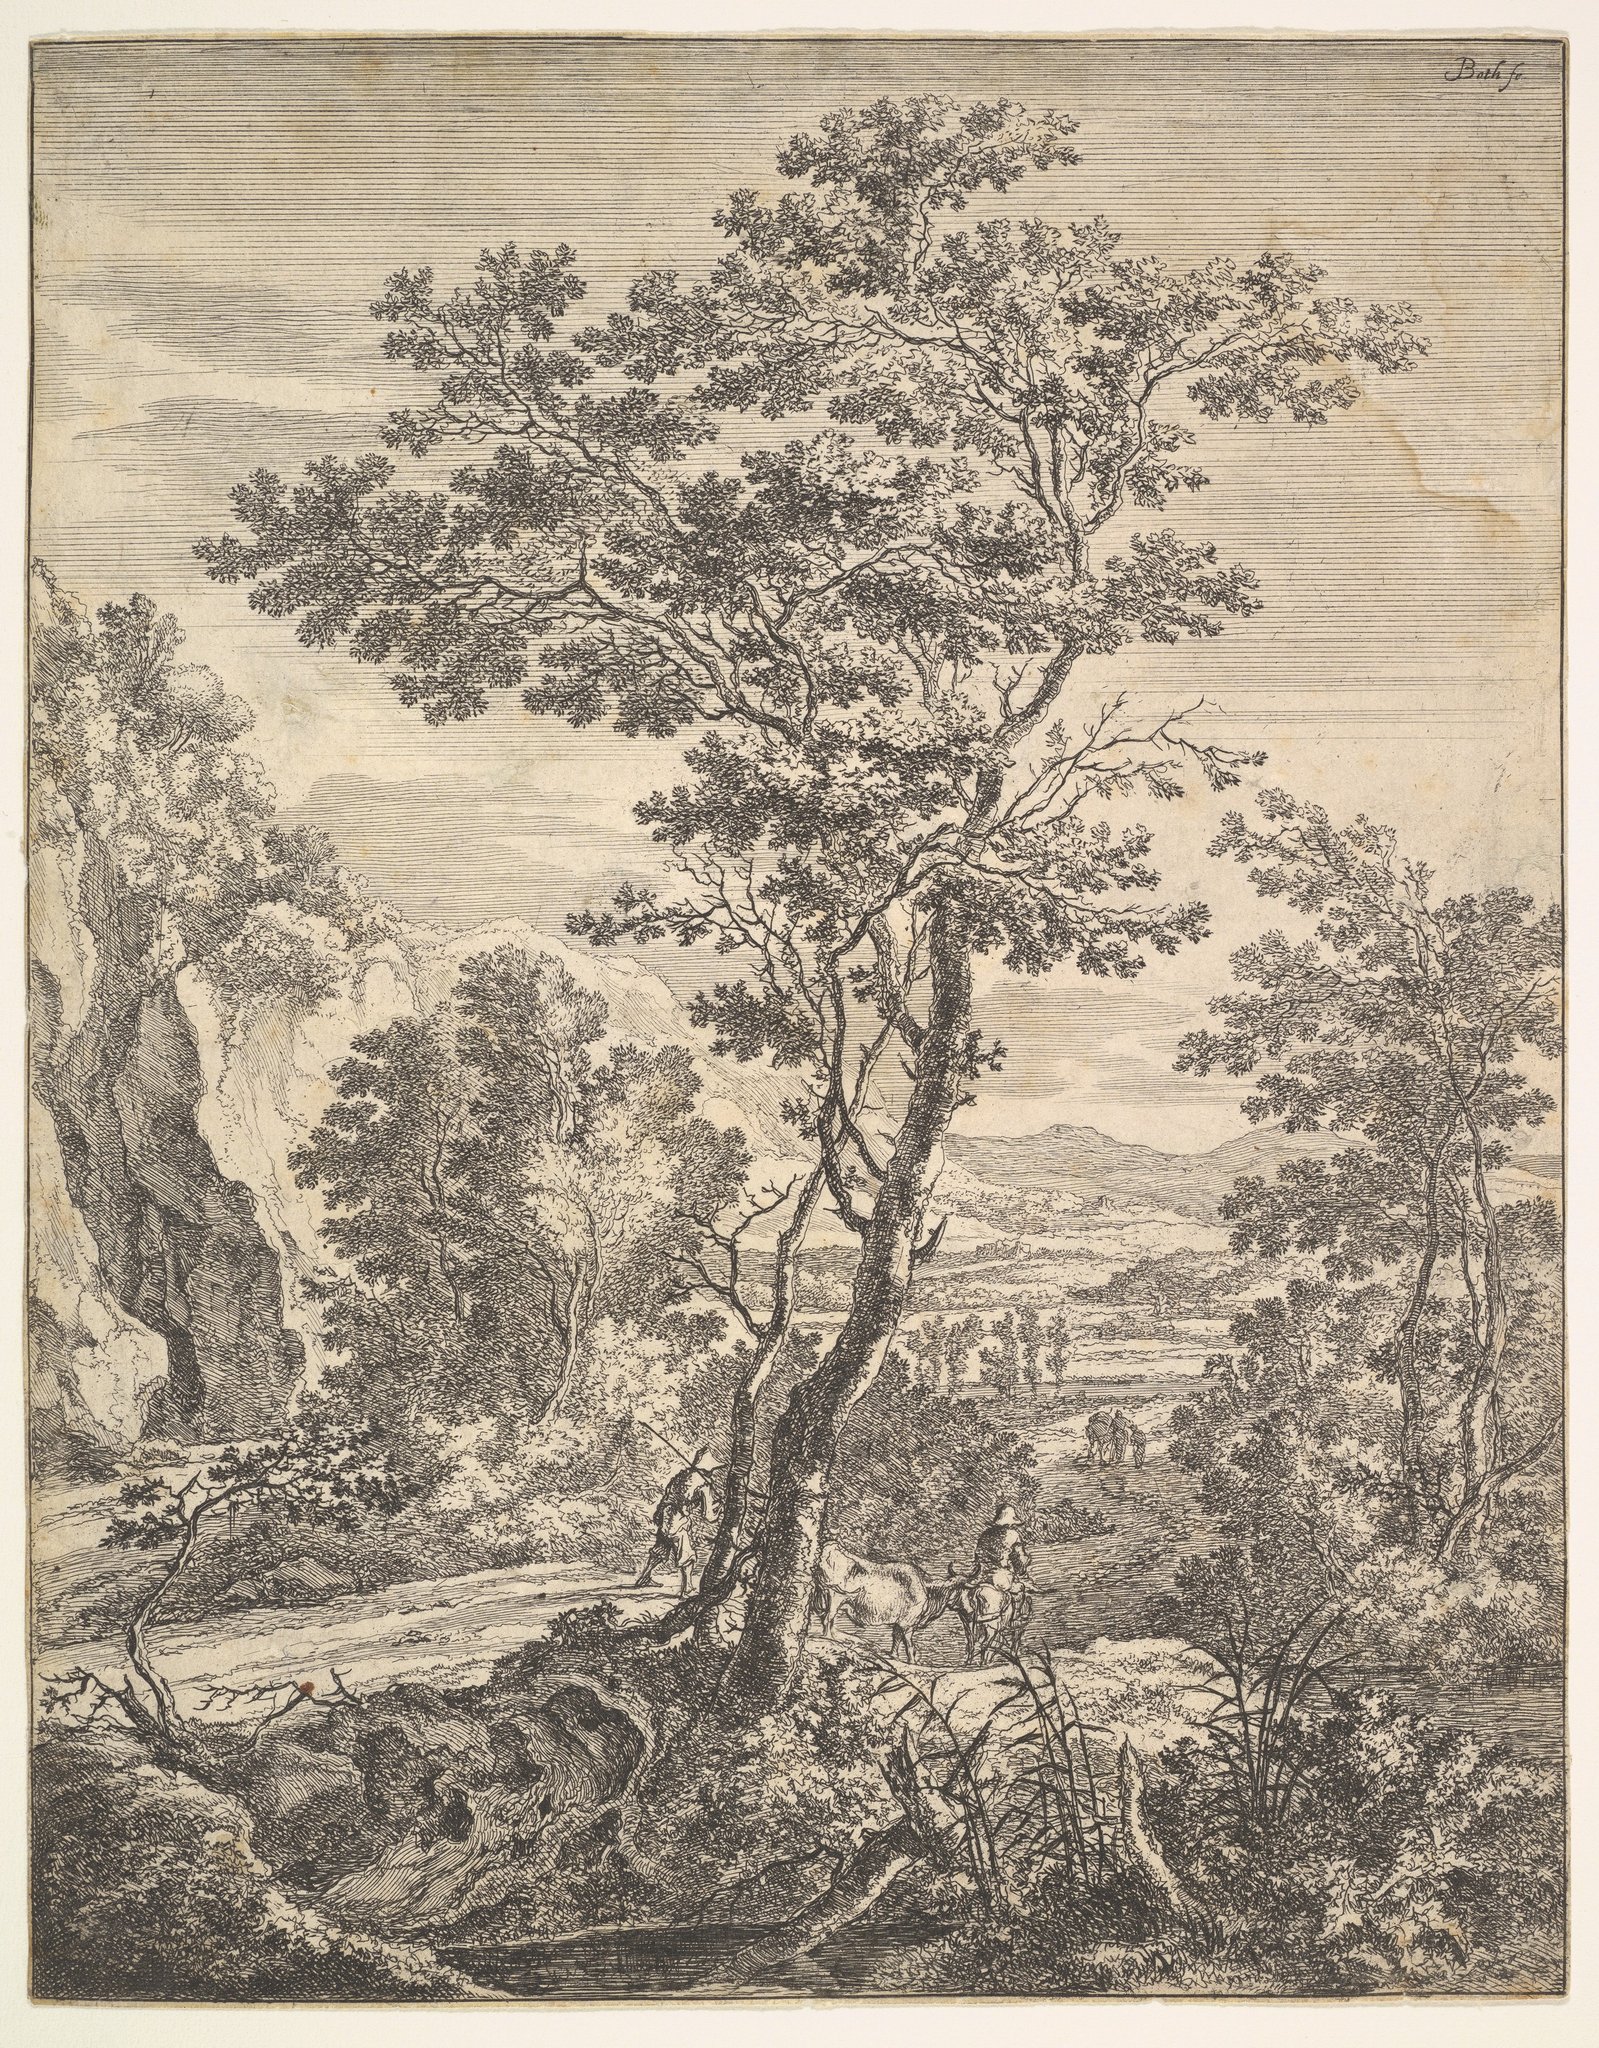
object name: print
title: The Large Tree, from "Upright Italian Landscapes"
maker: jan both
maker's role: artist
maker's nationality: dutch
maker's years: 1618-1652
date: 1620-1652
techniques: engraving, etching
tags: human figures,landscapes,trees